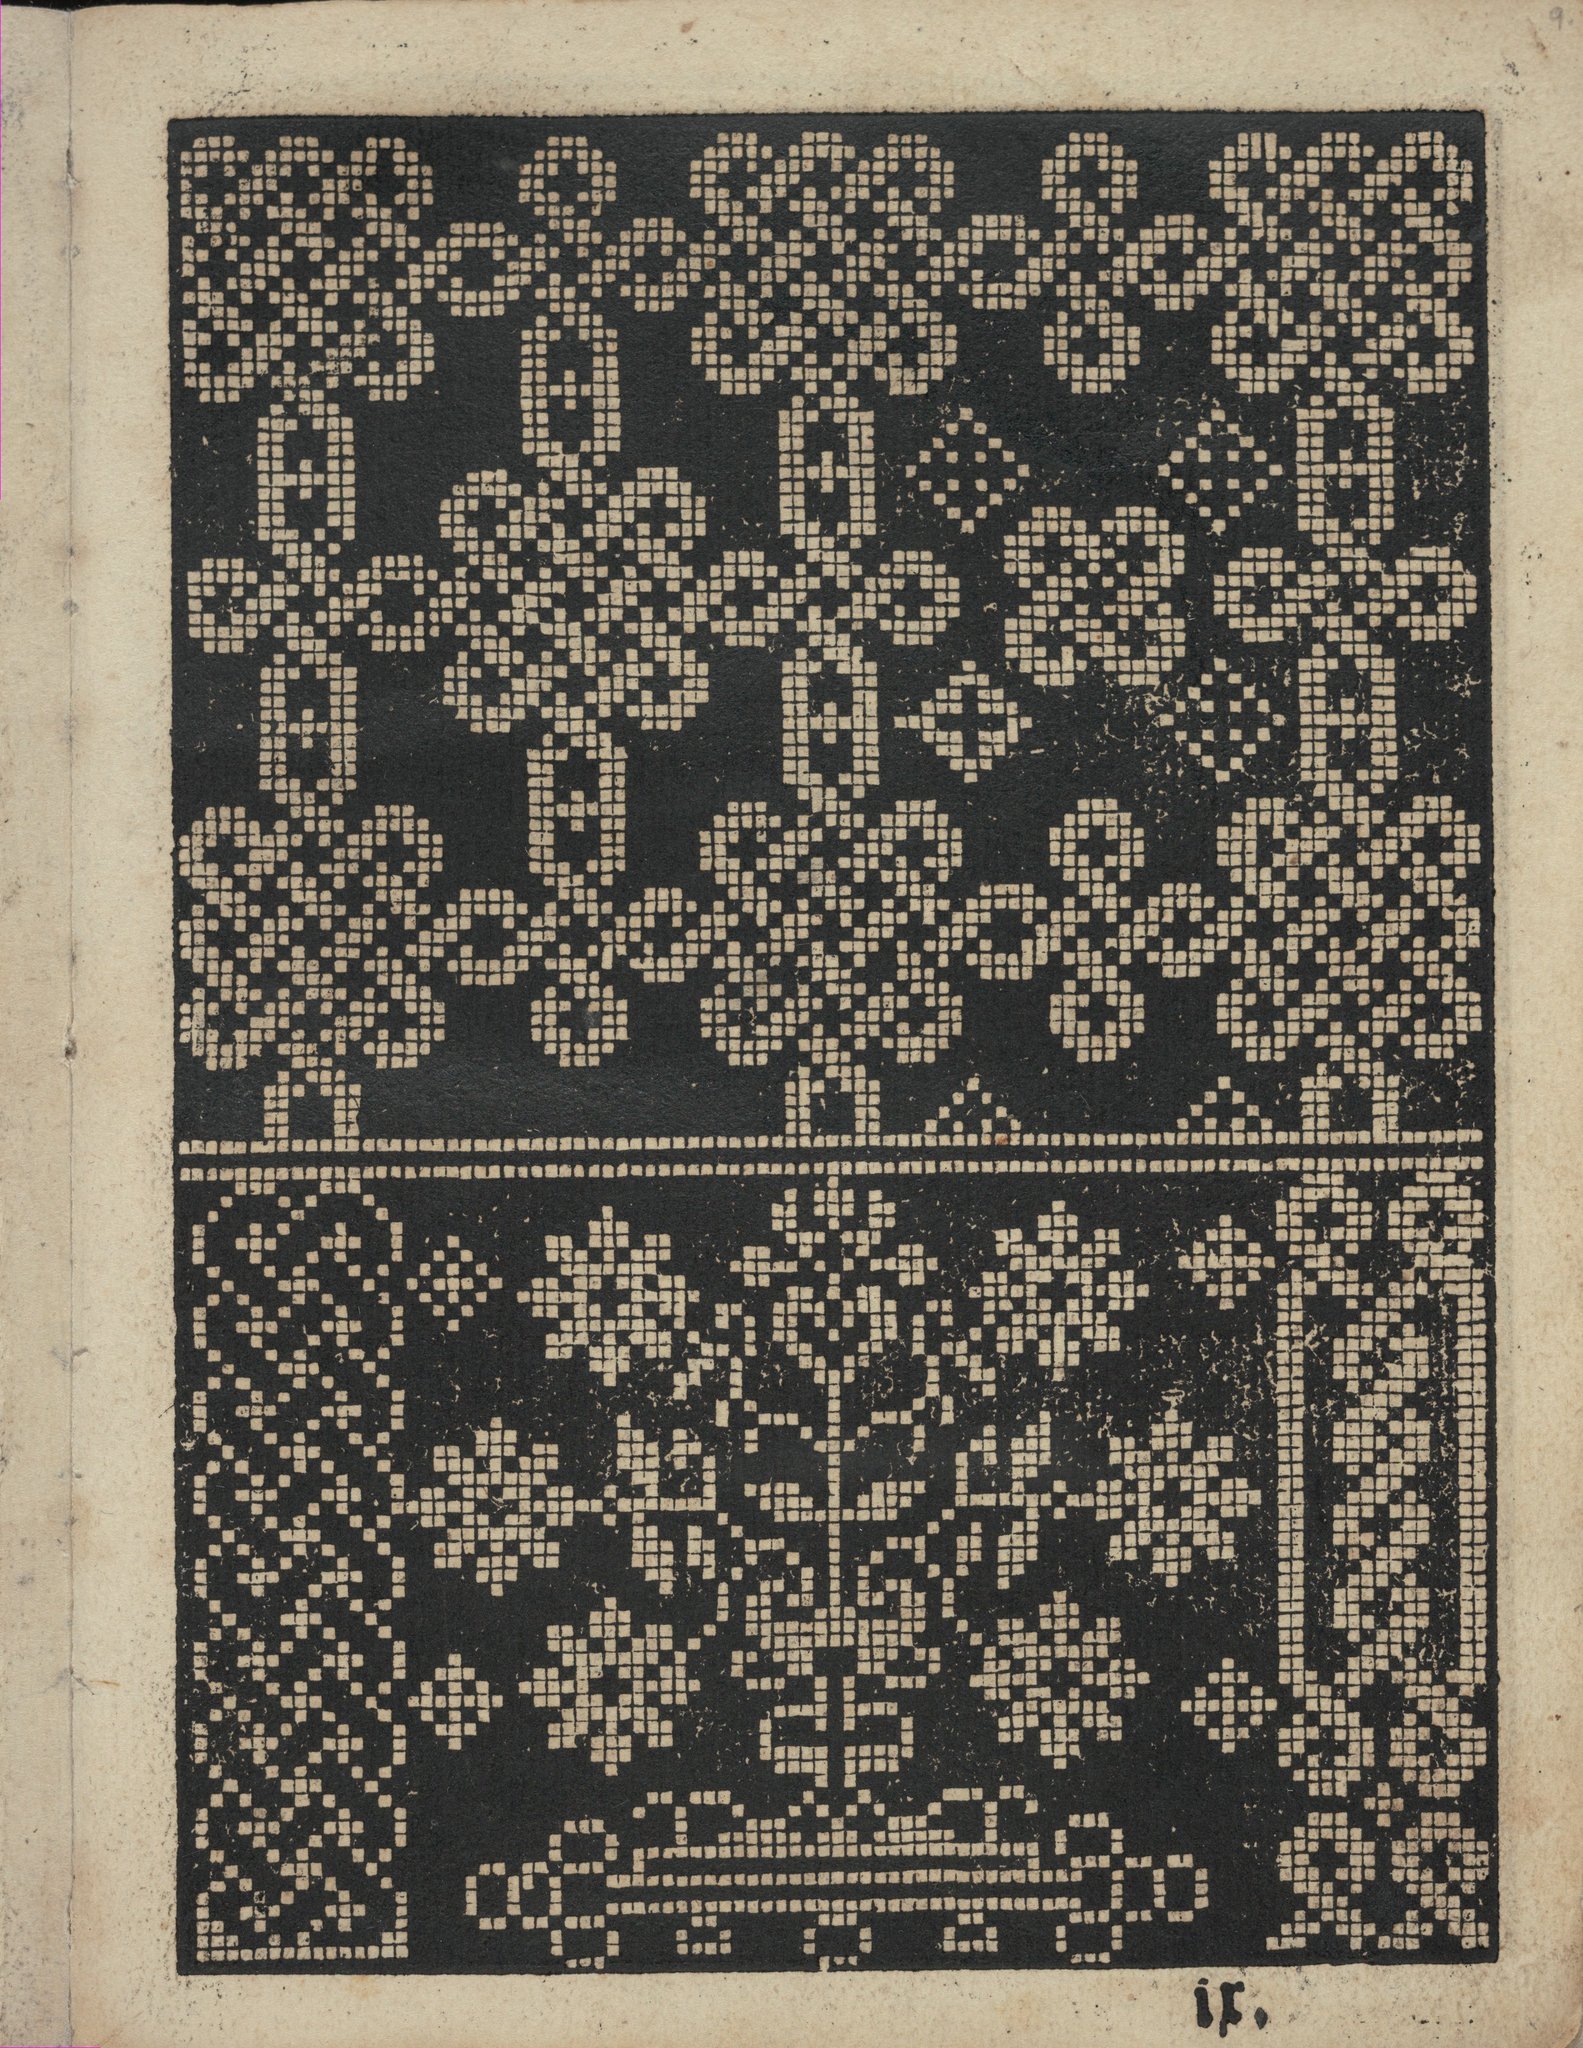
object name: book print ornament architecture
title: Libbretto nouellamete composto per maestro Domenico da Sera...lauorare di ogni sorte di punti, page 9 (recto)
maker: domenico da sera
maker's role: publisher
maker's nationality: french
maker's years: 1500-1599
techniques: woodcut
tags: ornament